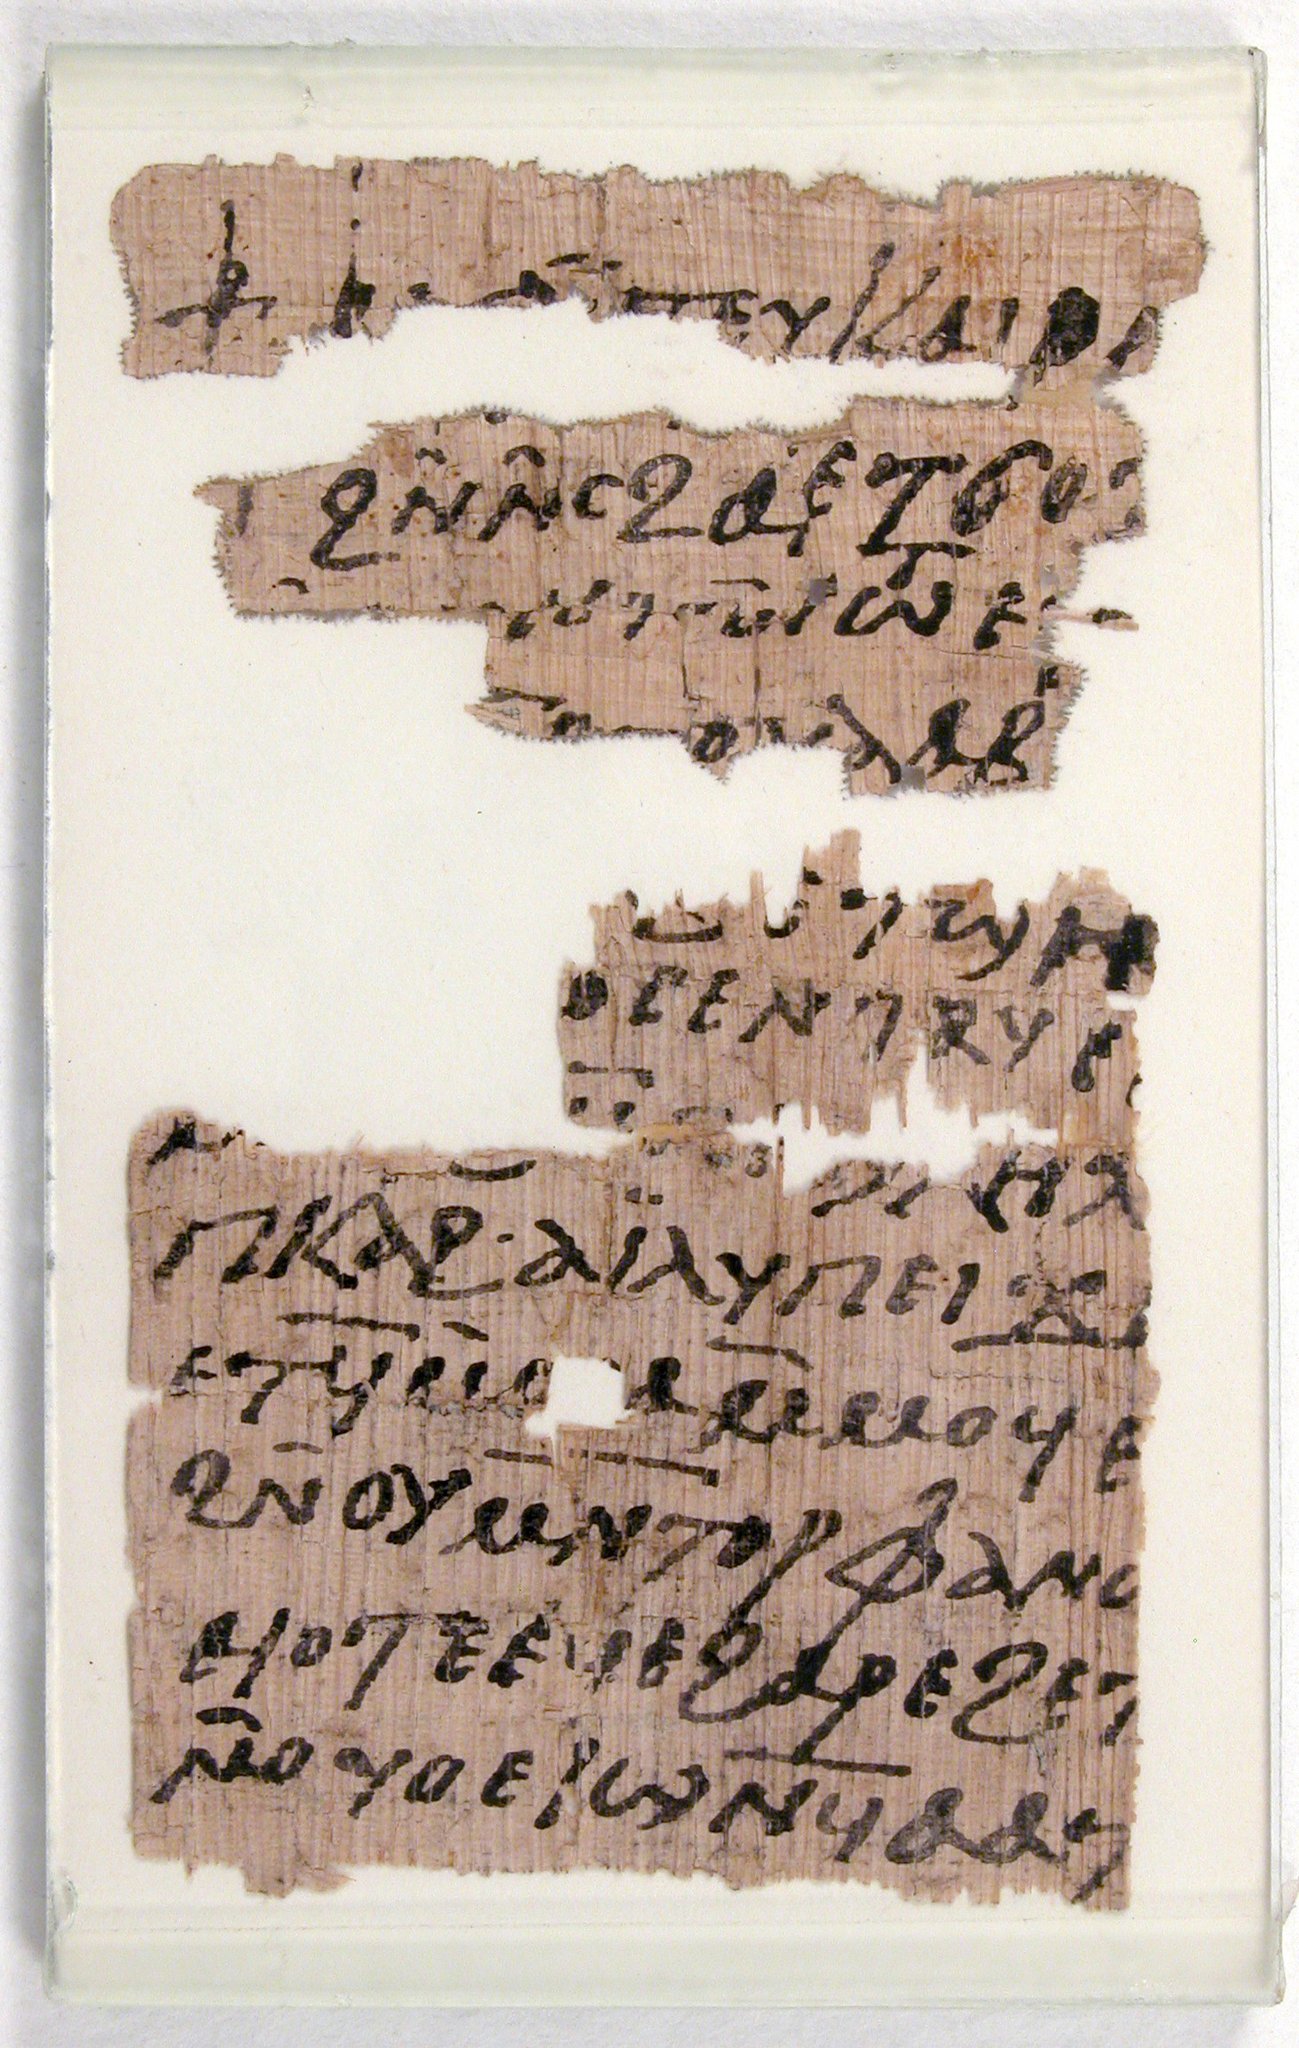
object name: fragment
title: Papyri Fragments of a Letter to Pesenthius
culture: coptic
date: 601-700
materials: ink, papyrus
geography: egypt